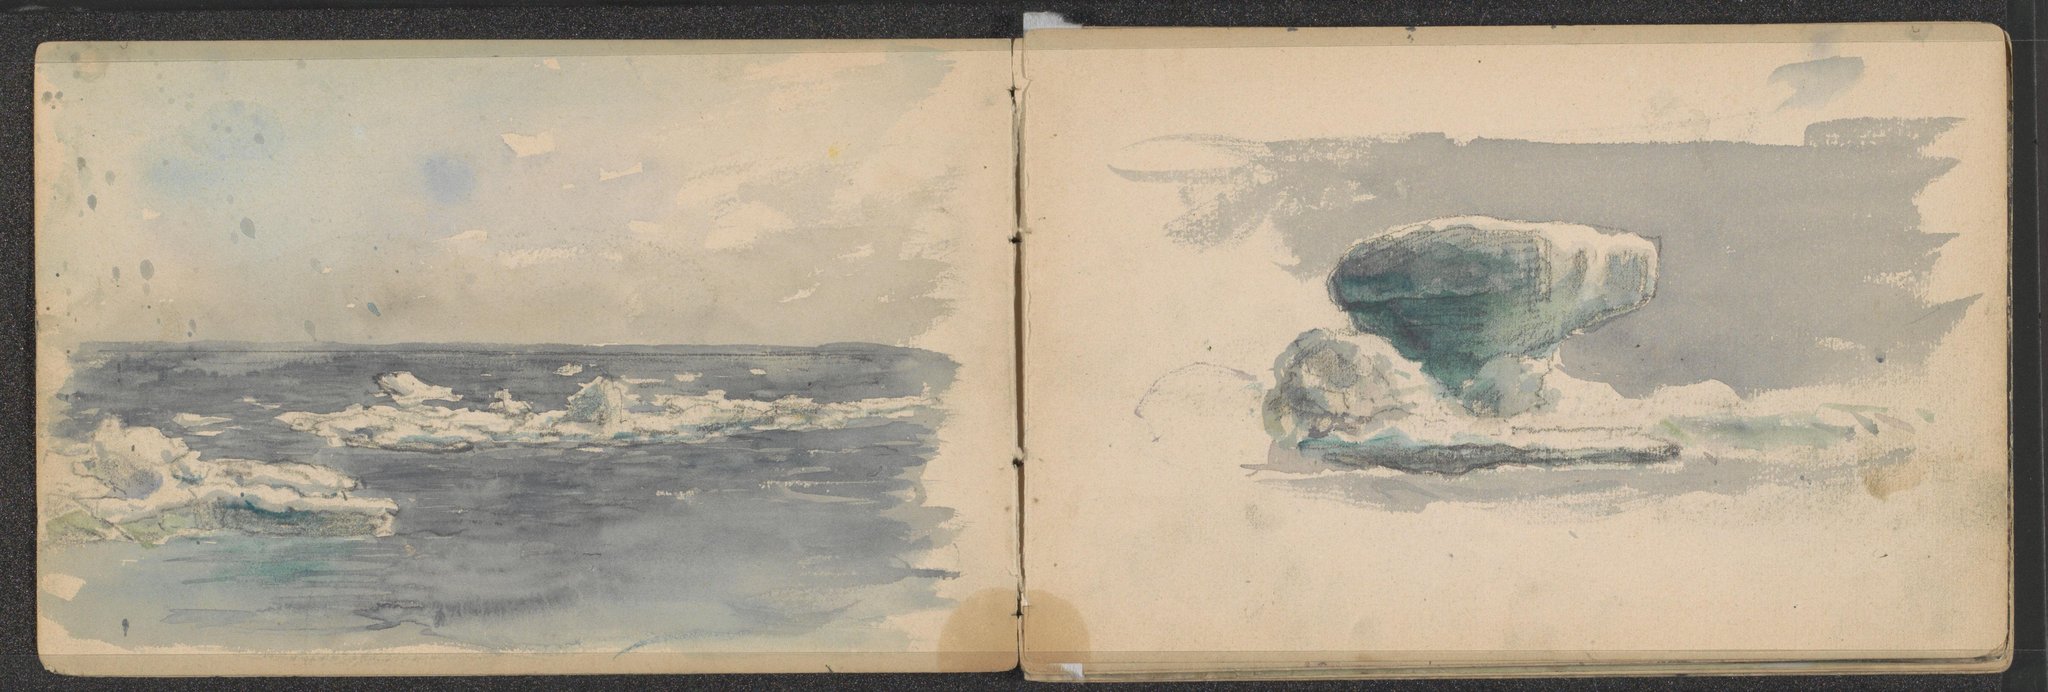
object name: sketchbook leaf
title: Gezicht op de Barentszzee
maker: louis apol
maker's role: draughtsman, painter, print maker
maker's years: 1850-1936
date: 1880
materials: chalk, paper, watercolor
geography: barentsz sea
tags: sea (seascape)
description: Blad 4 recto uit een schetsboek met 35 bladen betekend tijdens de expeditie naar Nova Zembla in 1880.